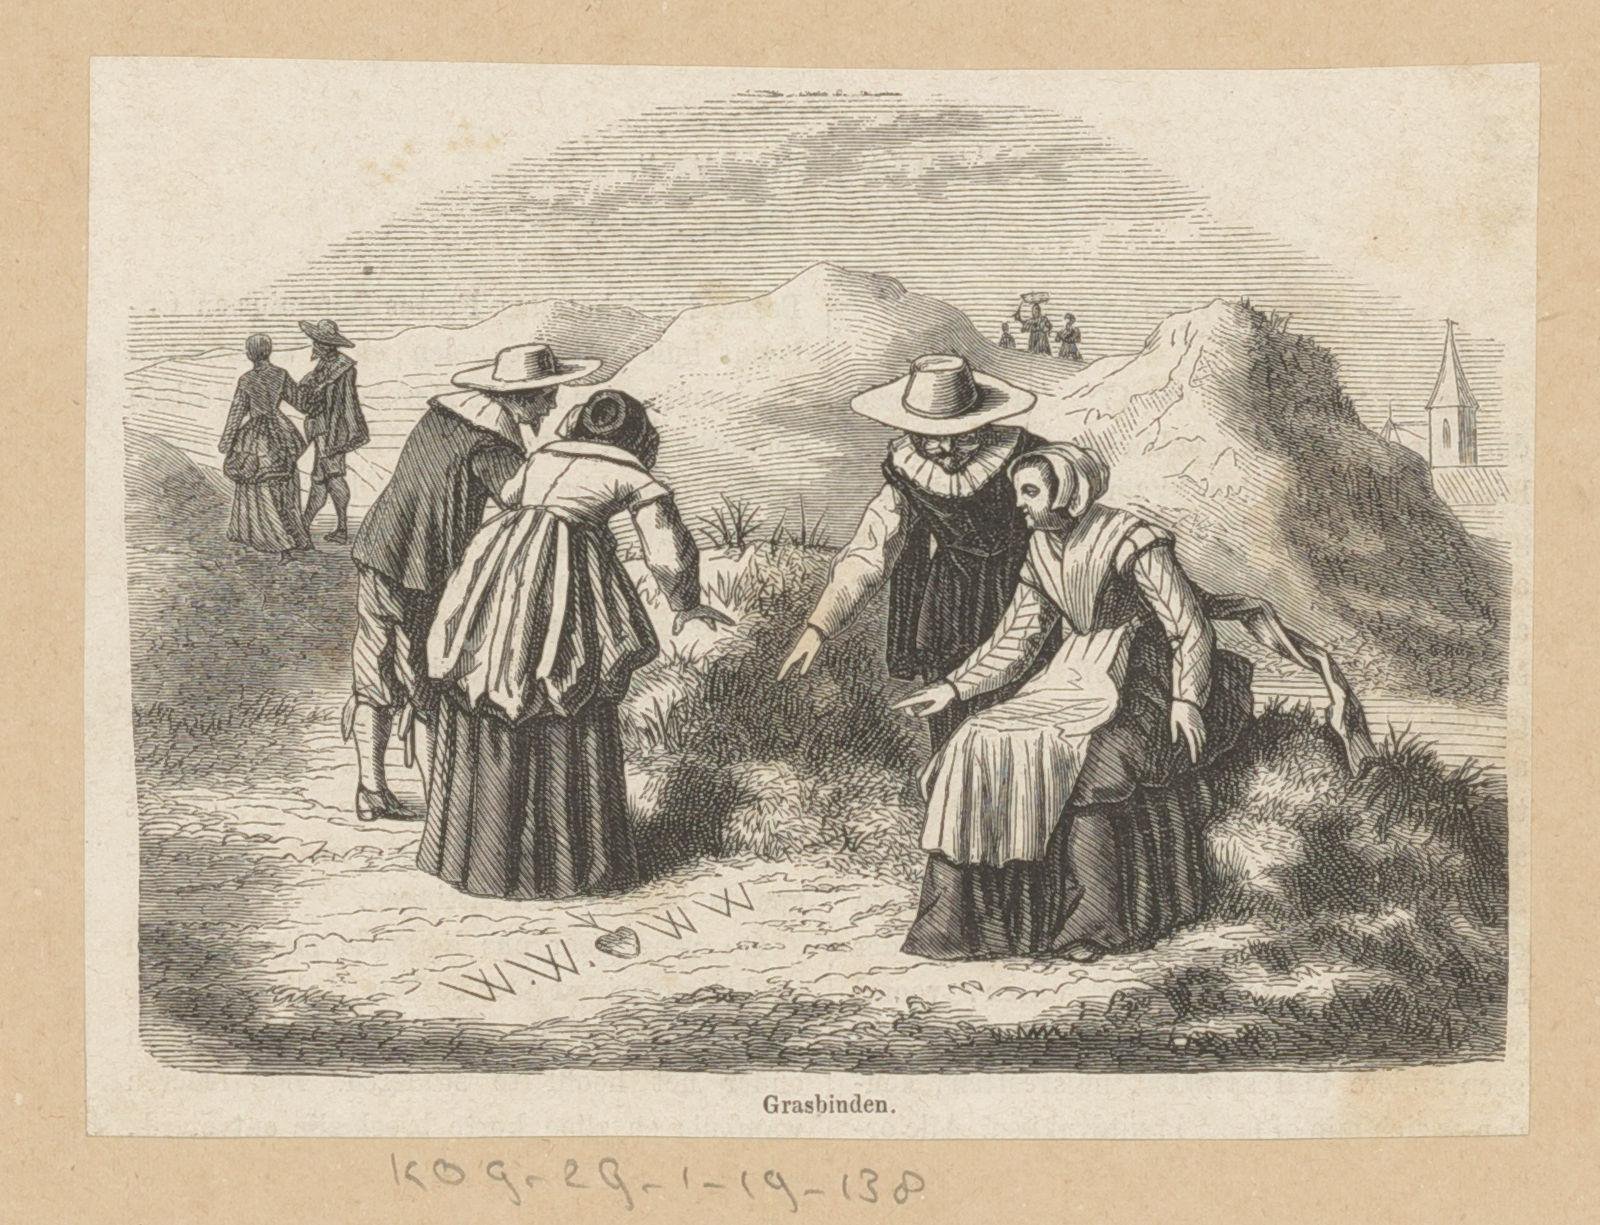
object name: book illustration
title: Grasbinden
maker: Anonymous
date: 1850-1899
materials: paper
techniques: engraving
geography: netherlands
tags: betrothal and marriage, lovers; courting, flirting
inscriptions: collector's mark: Lugt 1641, collector's mark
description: Liefdesparen in de duinen, zij schrijven boodschappen met grashalmen. Zeventiende-eeuwse voorstelling. Bedrukt met tekst op achterzijde. Onderwerpsrubrieken binnen de Atlas Zeden en Gewoonten: Des Menschen Begin, Midden en Einde. Bruiloft en huwelijk.